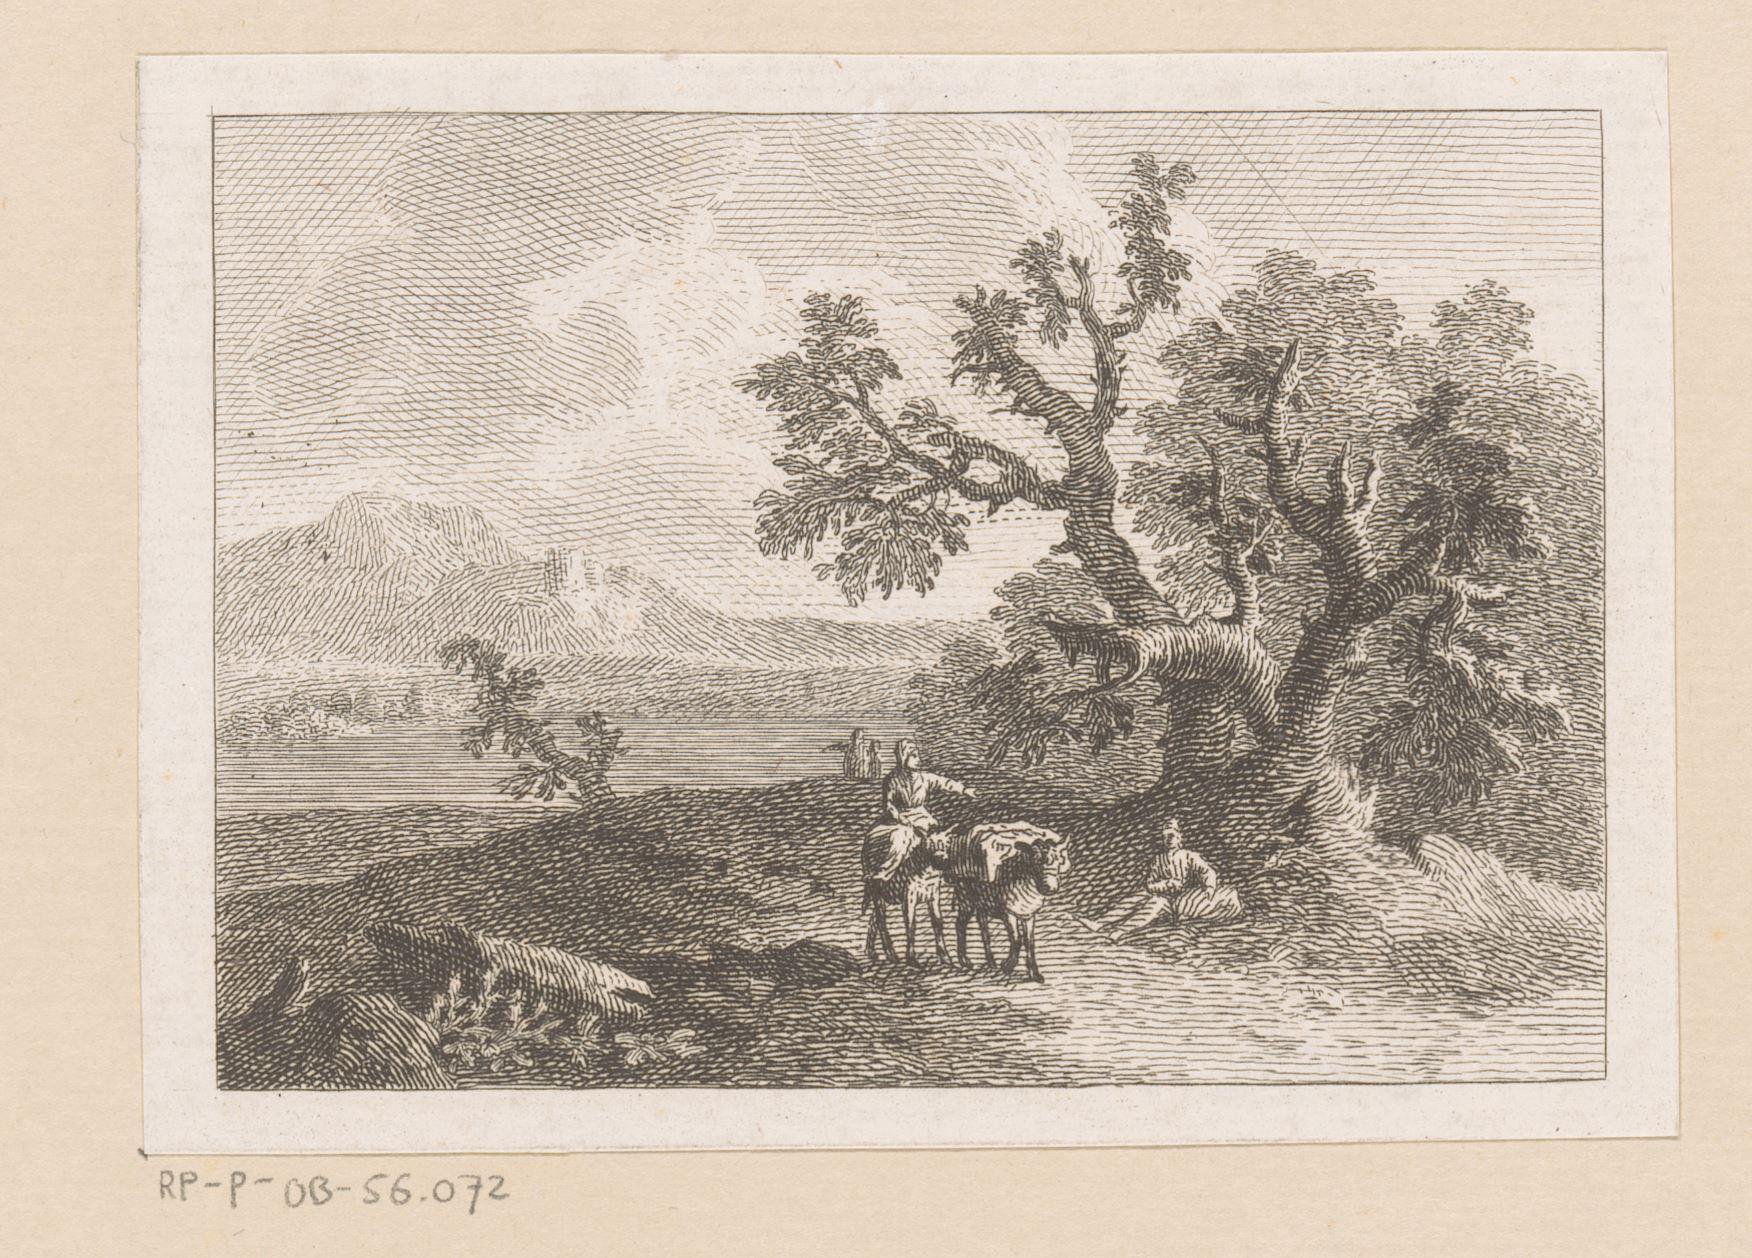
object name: print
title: Landschap met vrouw op een ezel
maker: joseph wagner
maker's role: painter, print maker, publisher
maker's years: 1706-1780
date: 1739-1780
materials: paper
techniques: etching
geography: venice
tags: riding a horse, ass, or mule; rider, horseman, landscapes, ass, donkey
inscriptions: collector's mark: Lugt 240